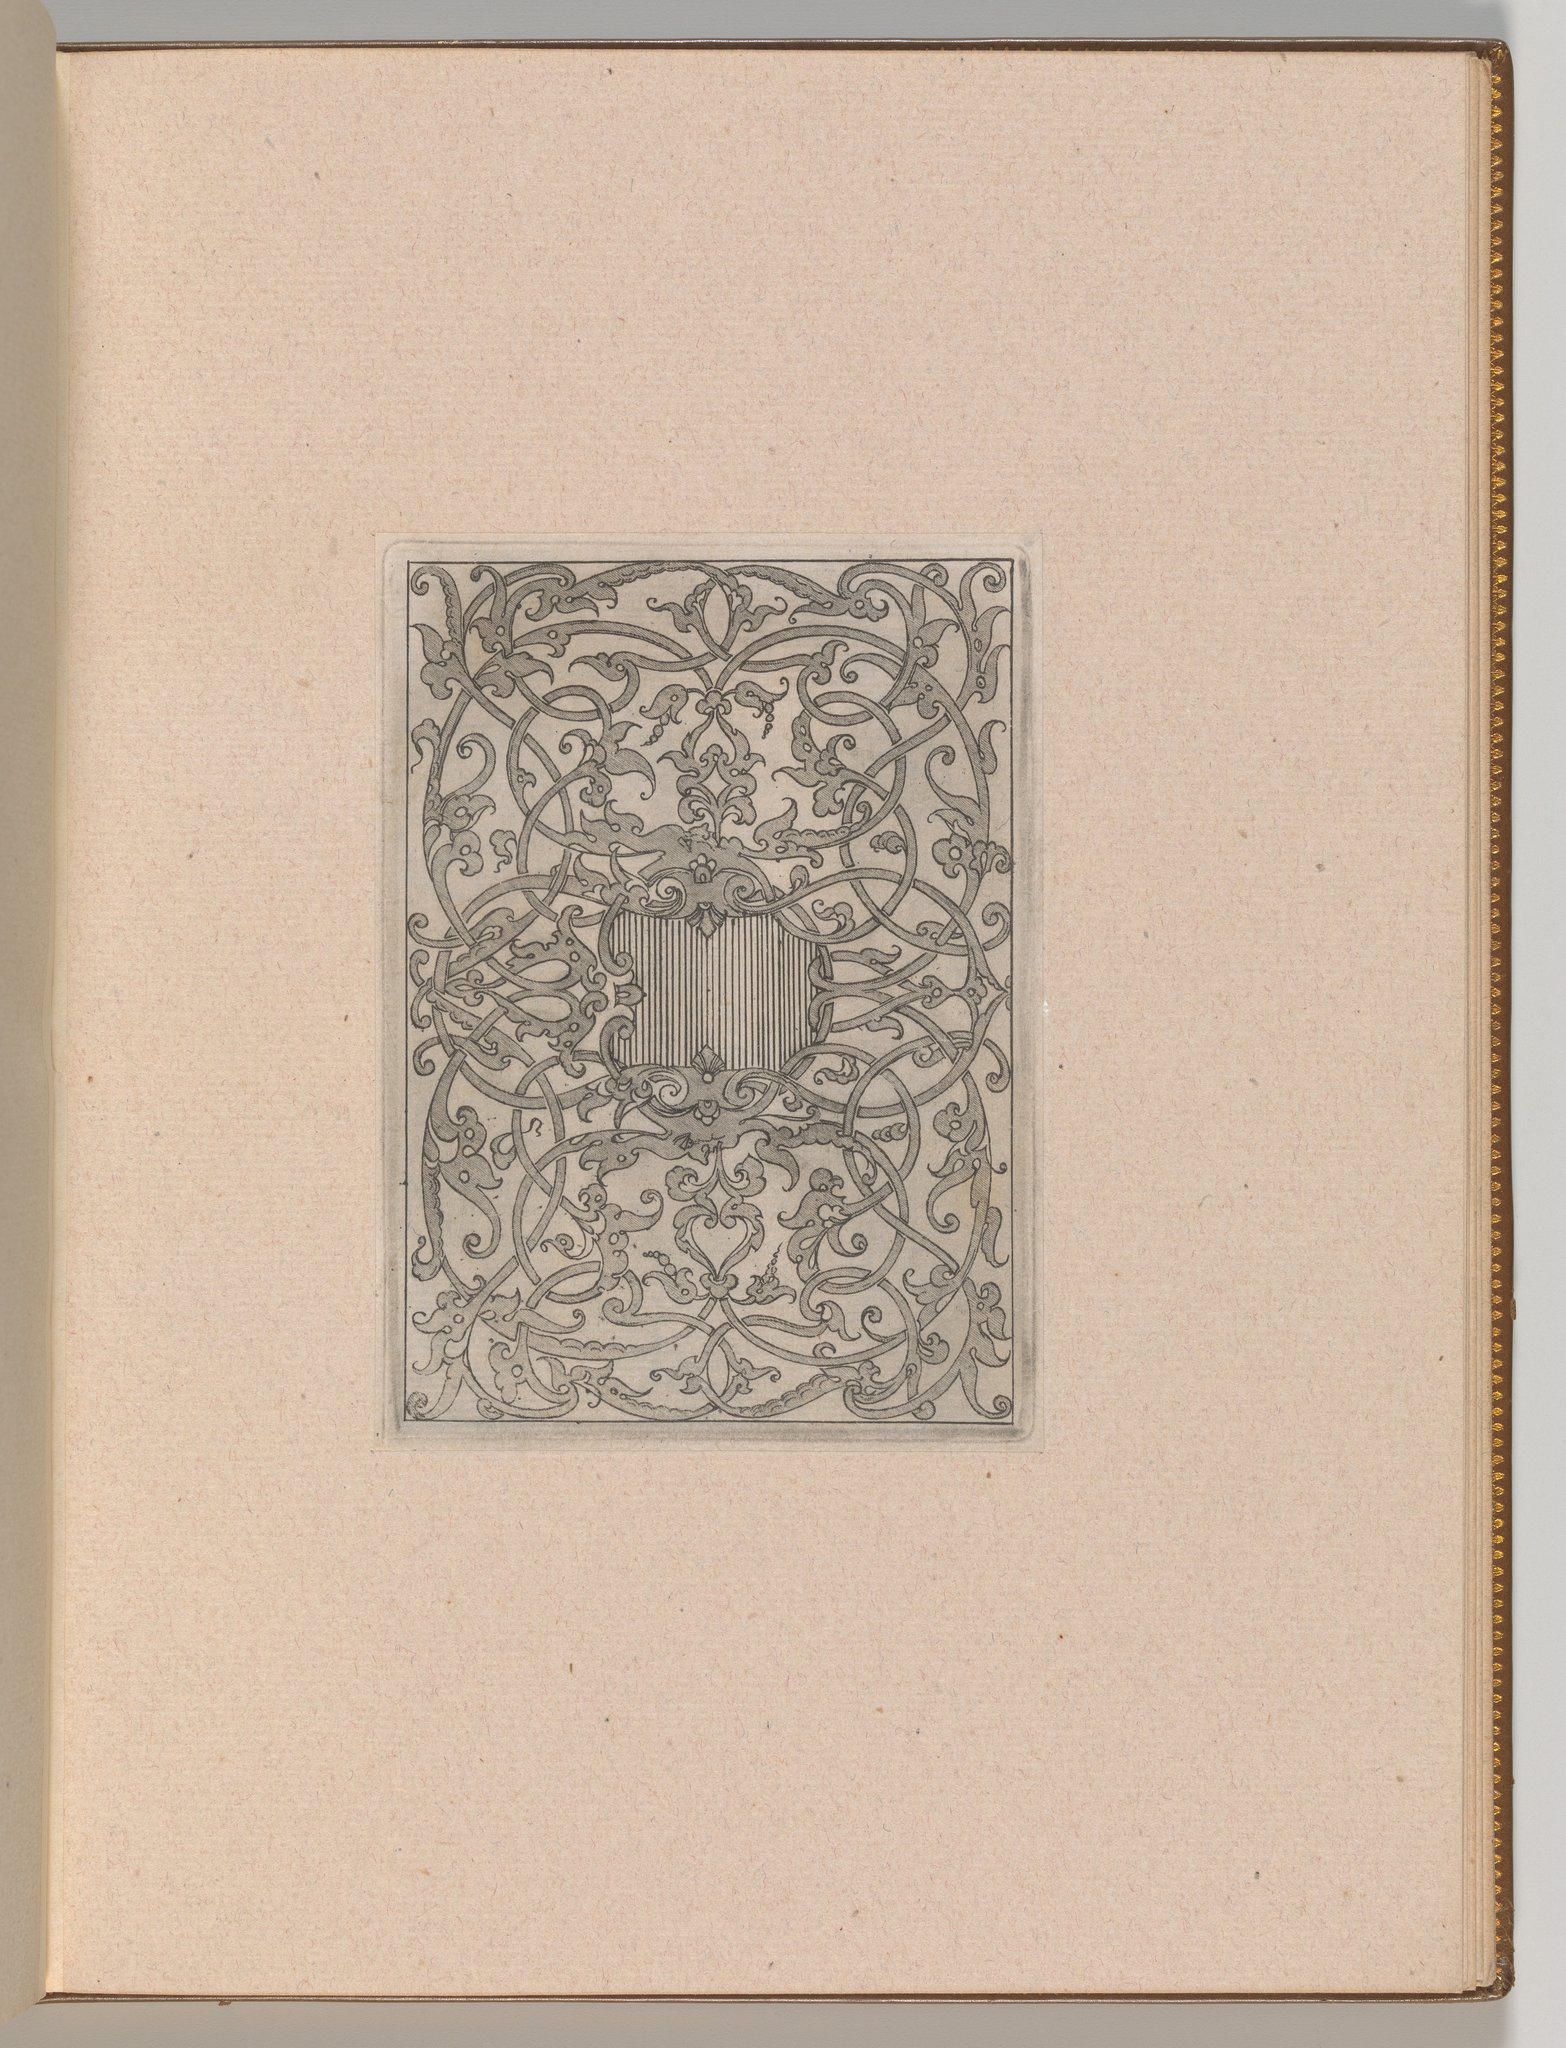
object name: album print ornament architecture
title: Copies after the 'Livre contenant passement de moresques' (plate 6)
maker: jacques androuet du cerceau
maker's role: artist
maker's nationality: french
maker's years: 1510-1585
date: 1801-1900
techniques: etching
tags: ornament